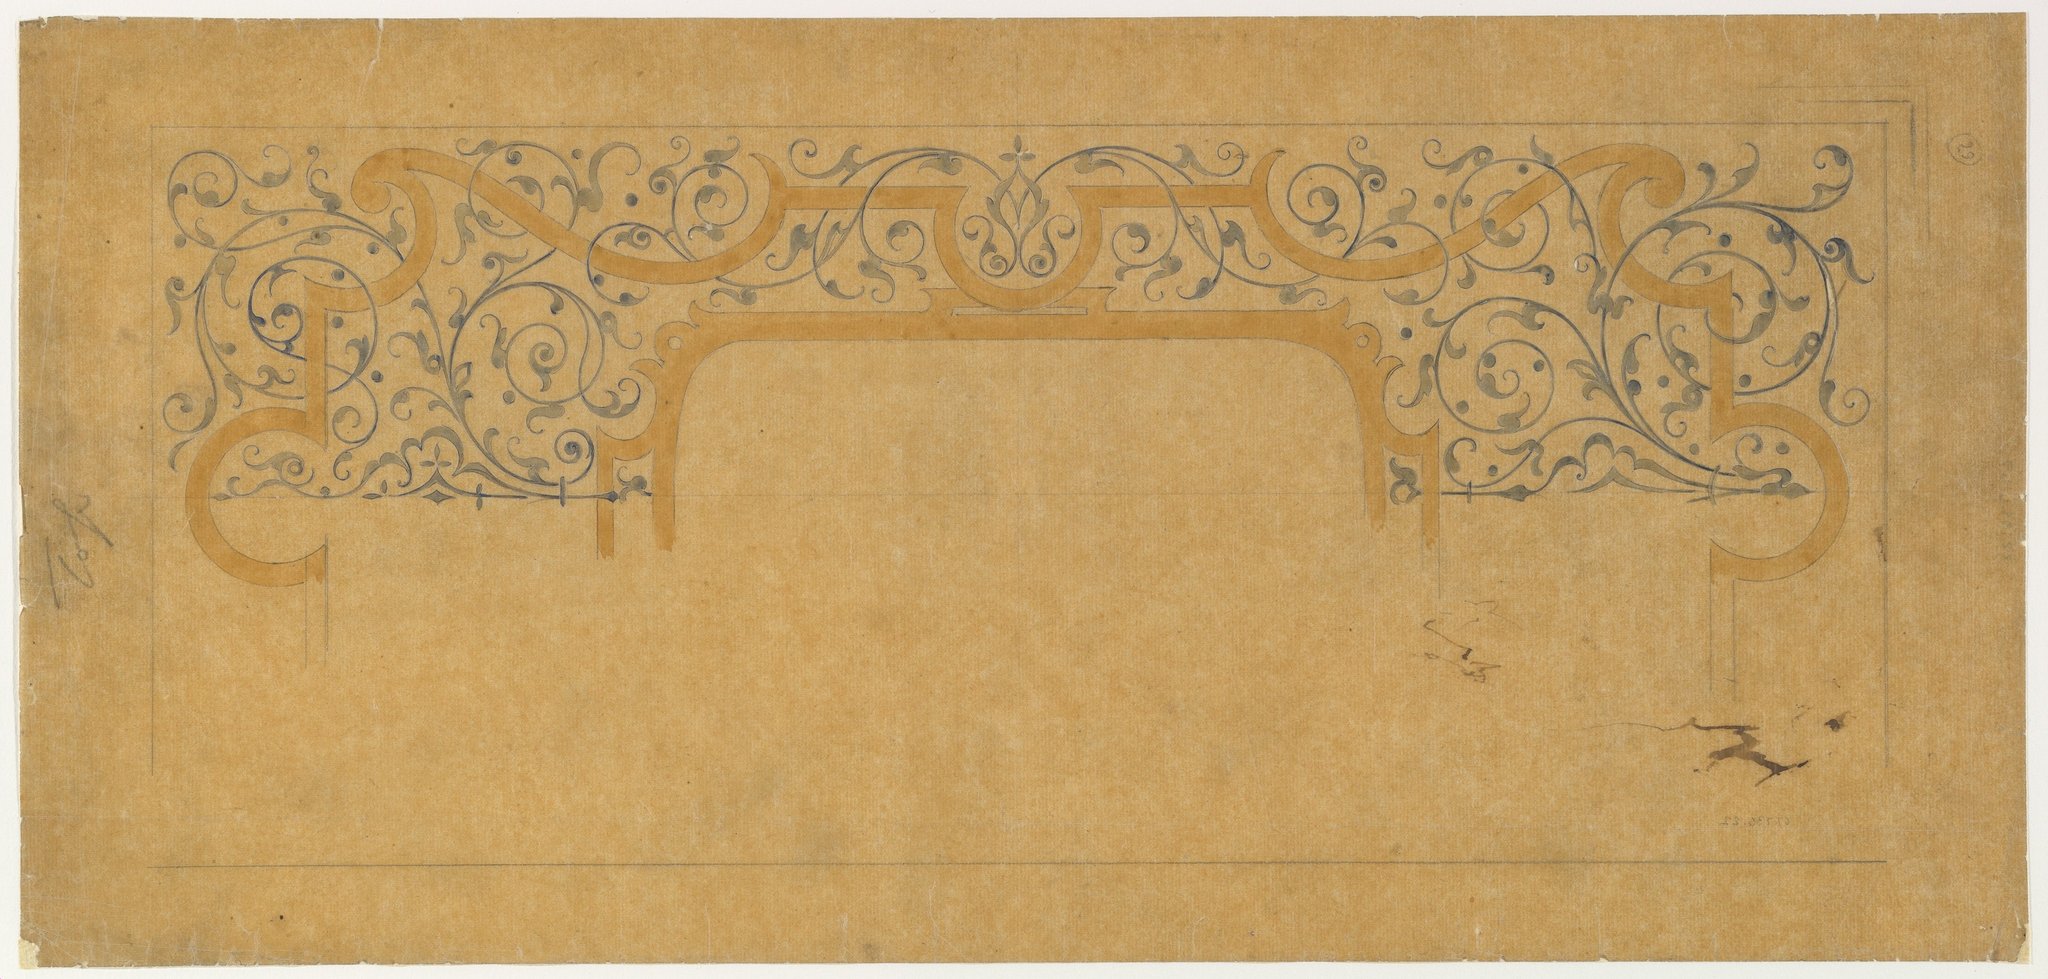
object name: drawing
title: Rinceau and Strapwork Ornament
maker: john gregory crace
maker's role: artist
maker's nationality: british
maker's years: 1809-1889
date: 1801-1900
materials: graphite, watercolor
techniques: brush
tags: ornament